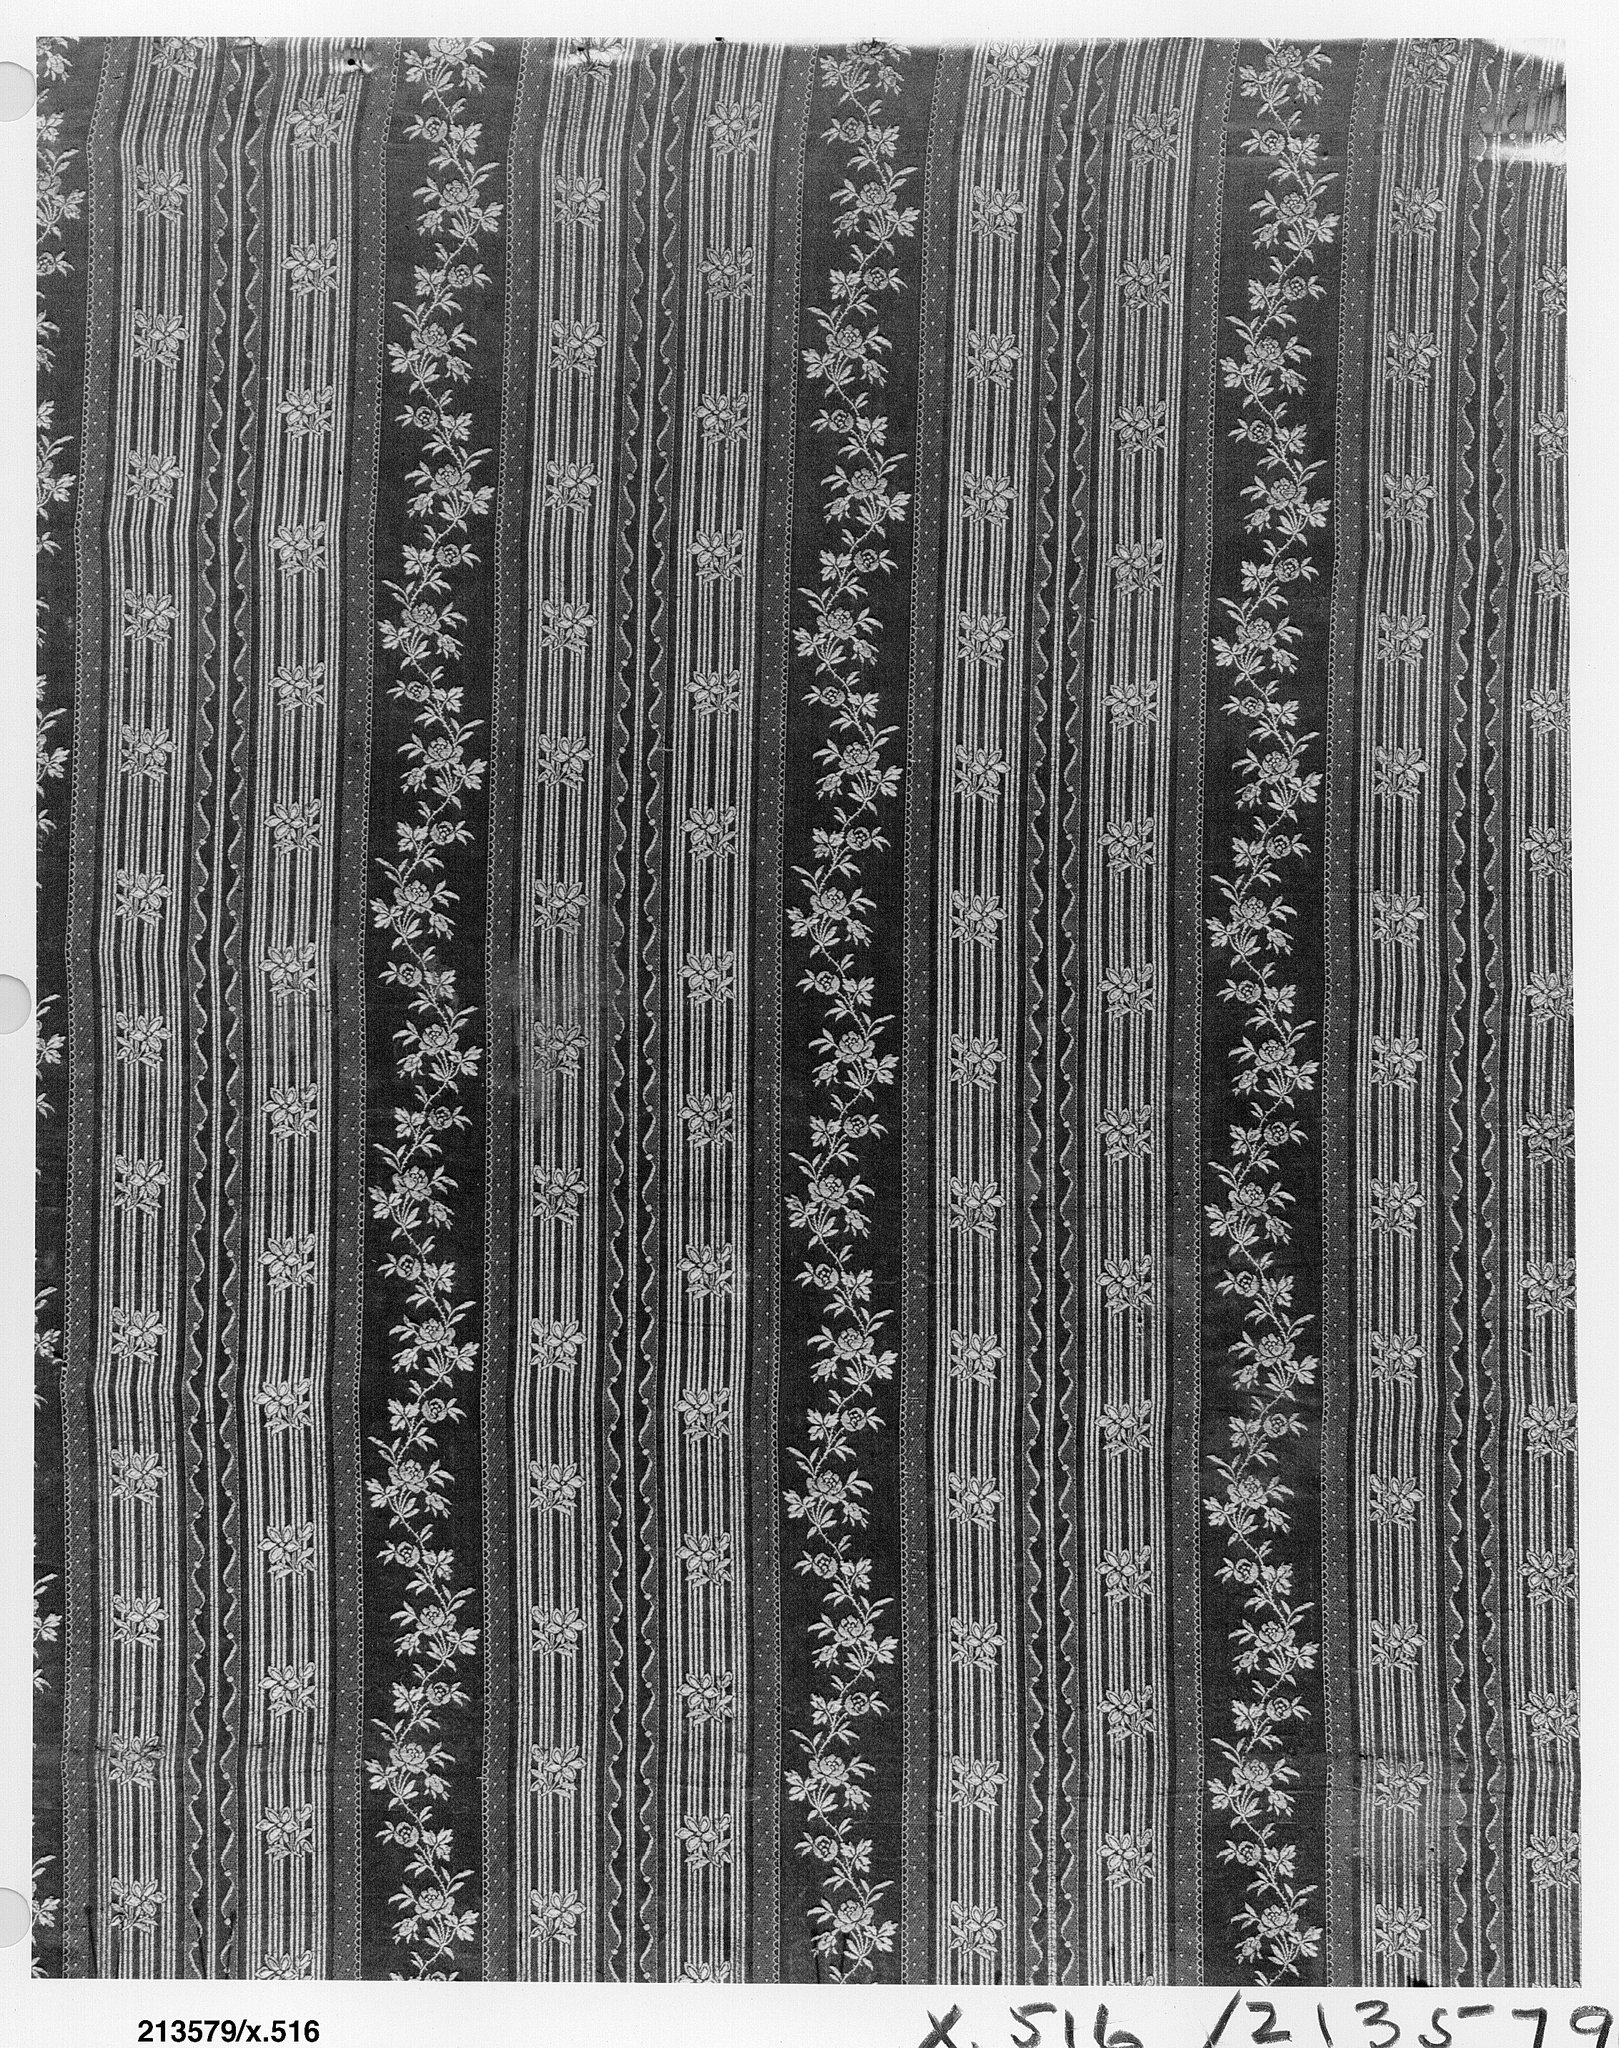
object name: breadth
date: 1701-1800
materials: silk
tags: flowers